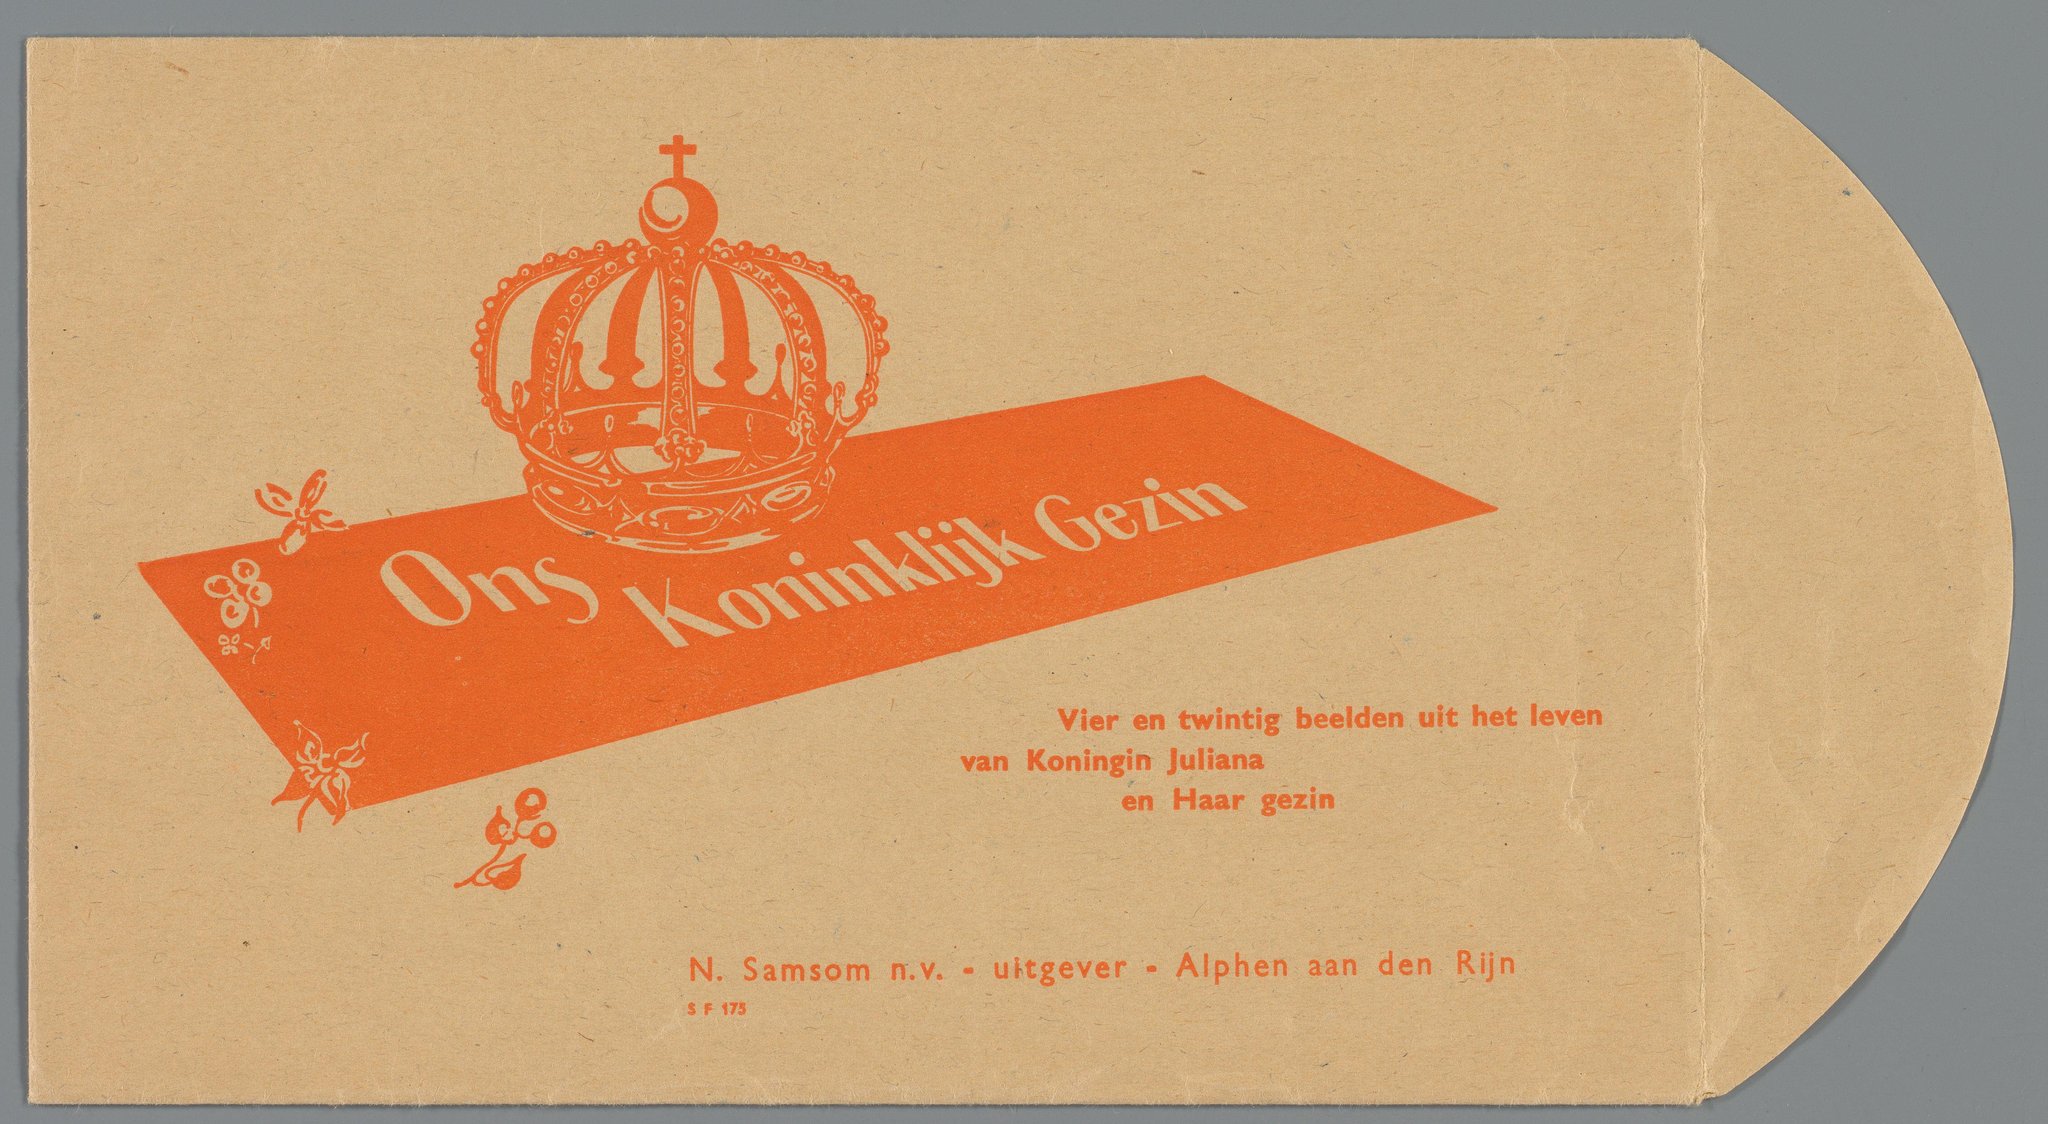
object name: envelope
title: Ons Koninklijk Gezin Vier en twintig beelden uit het leven van Koningin Juliana en Haar gezin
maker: Anonymous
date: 1882-1959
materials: paper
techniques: letterpress printing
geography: alphen aan den rijn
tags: letter, envelope